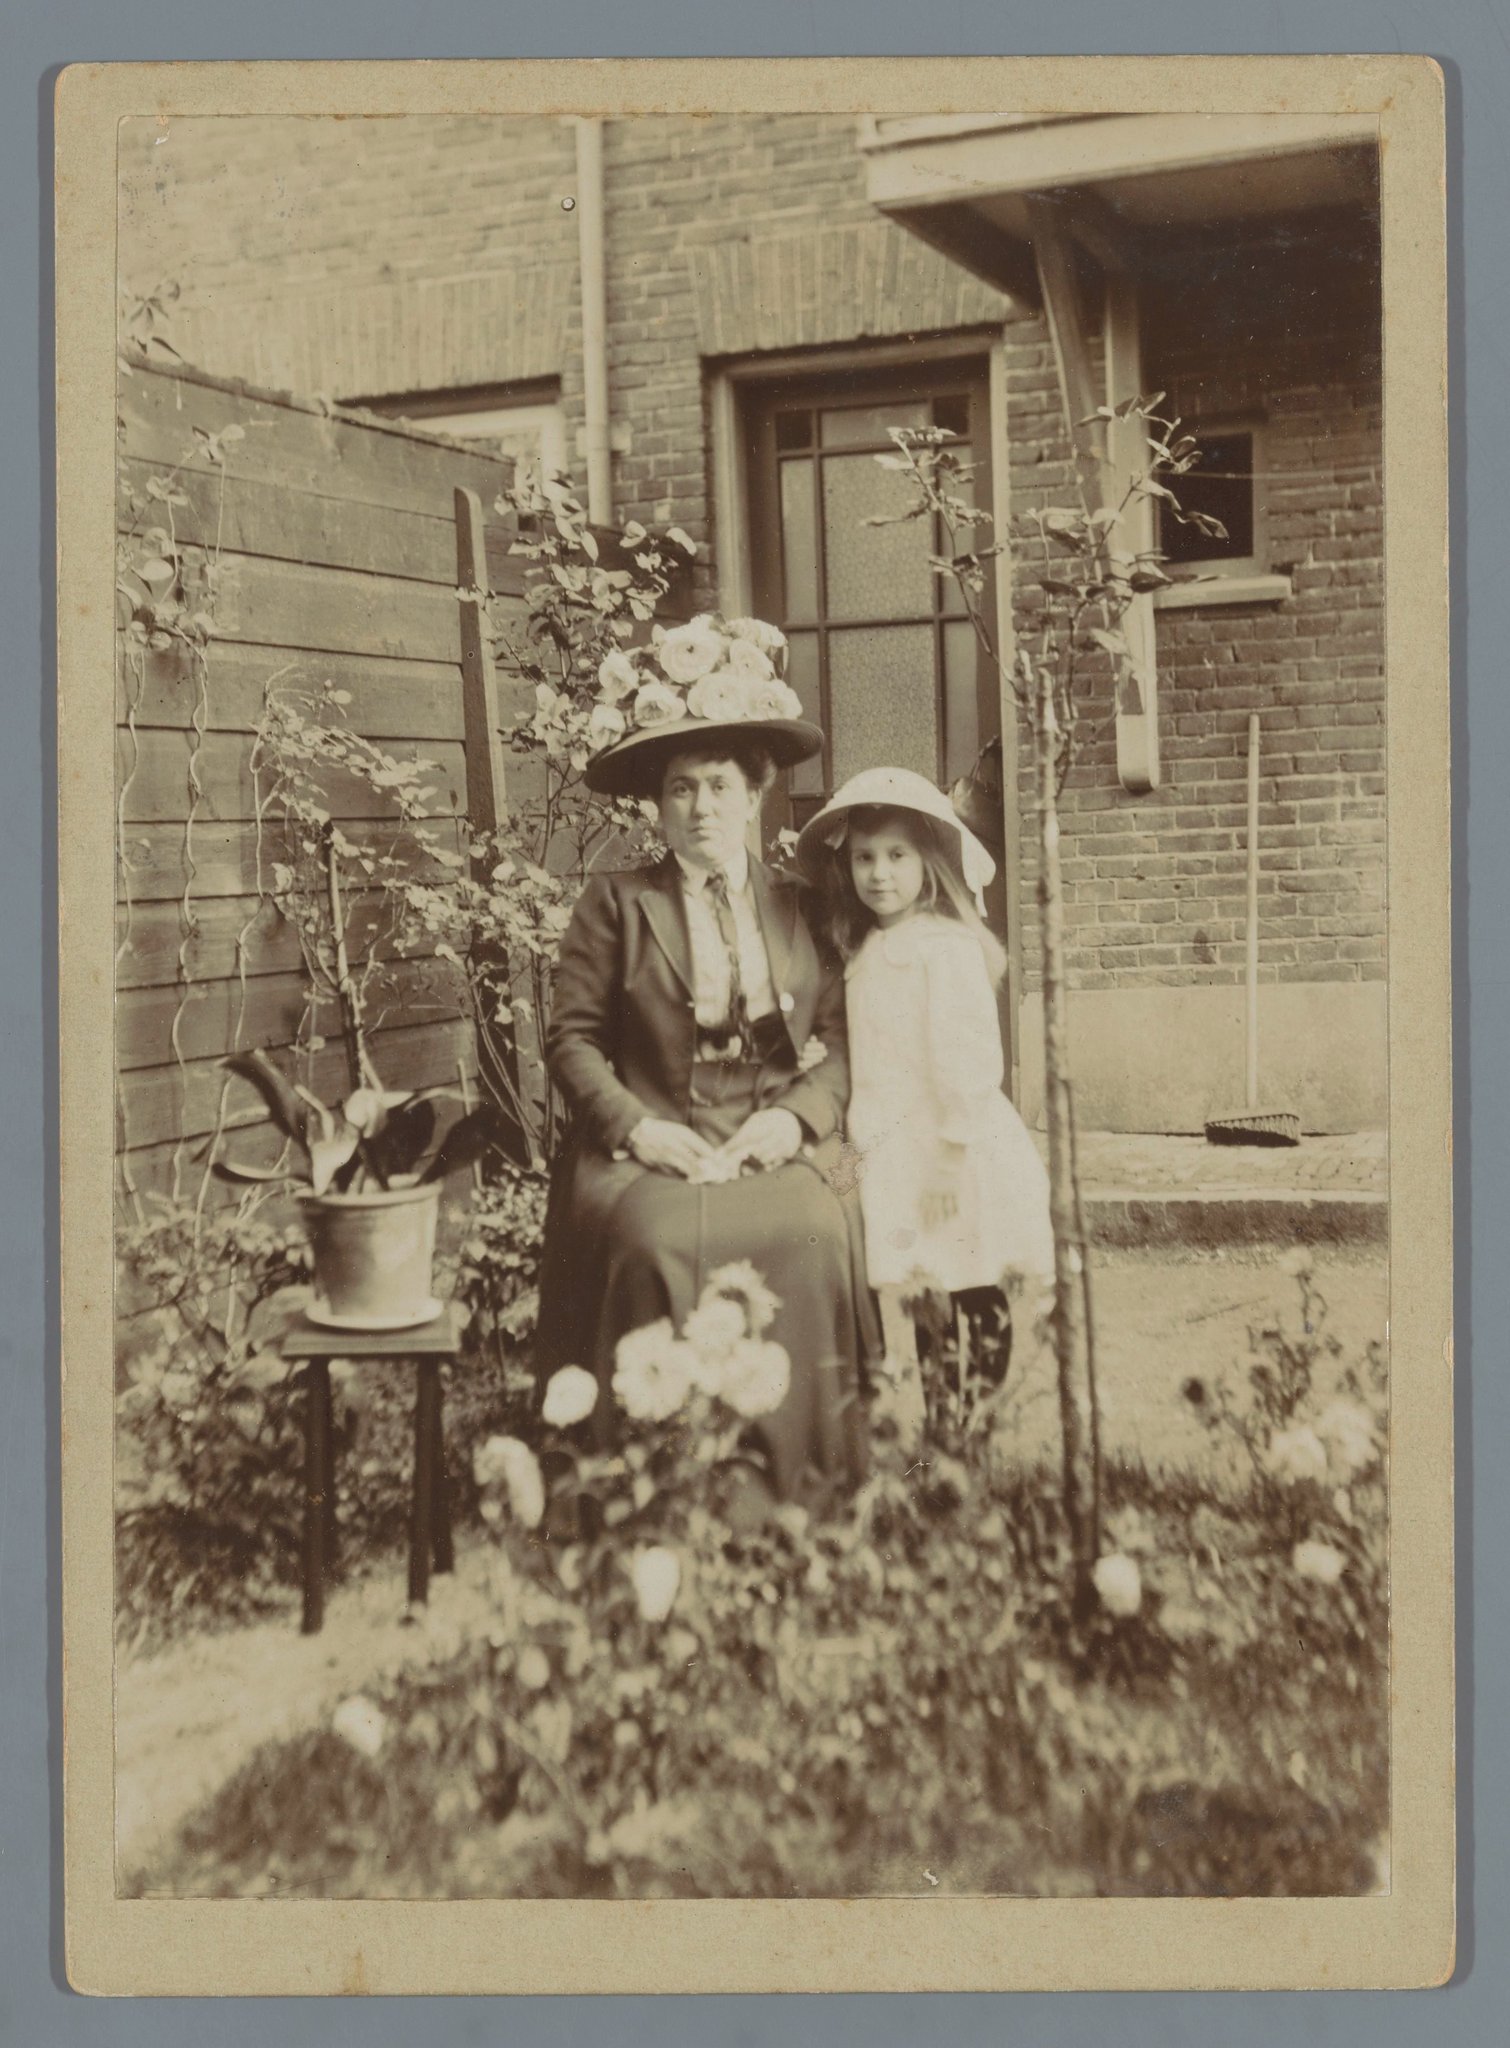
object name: photograph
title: Portret van een onbekende vrouw met een kind in een achtertuin te Den Haag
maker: Anonymous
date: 1900-1915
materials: paper, cardboard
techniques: gelatin silver print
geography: the hague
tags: mother and baby or young child, backyard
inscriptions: inscription: ‘Den Haag. Malakkastraat No. 49’